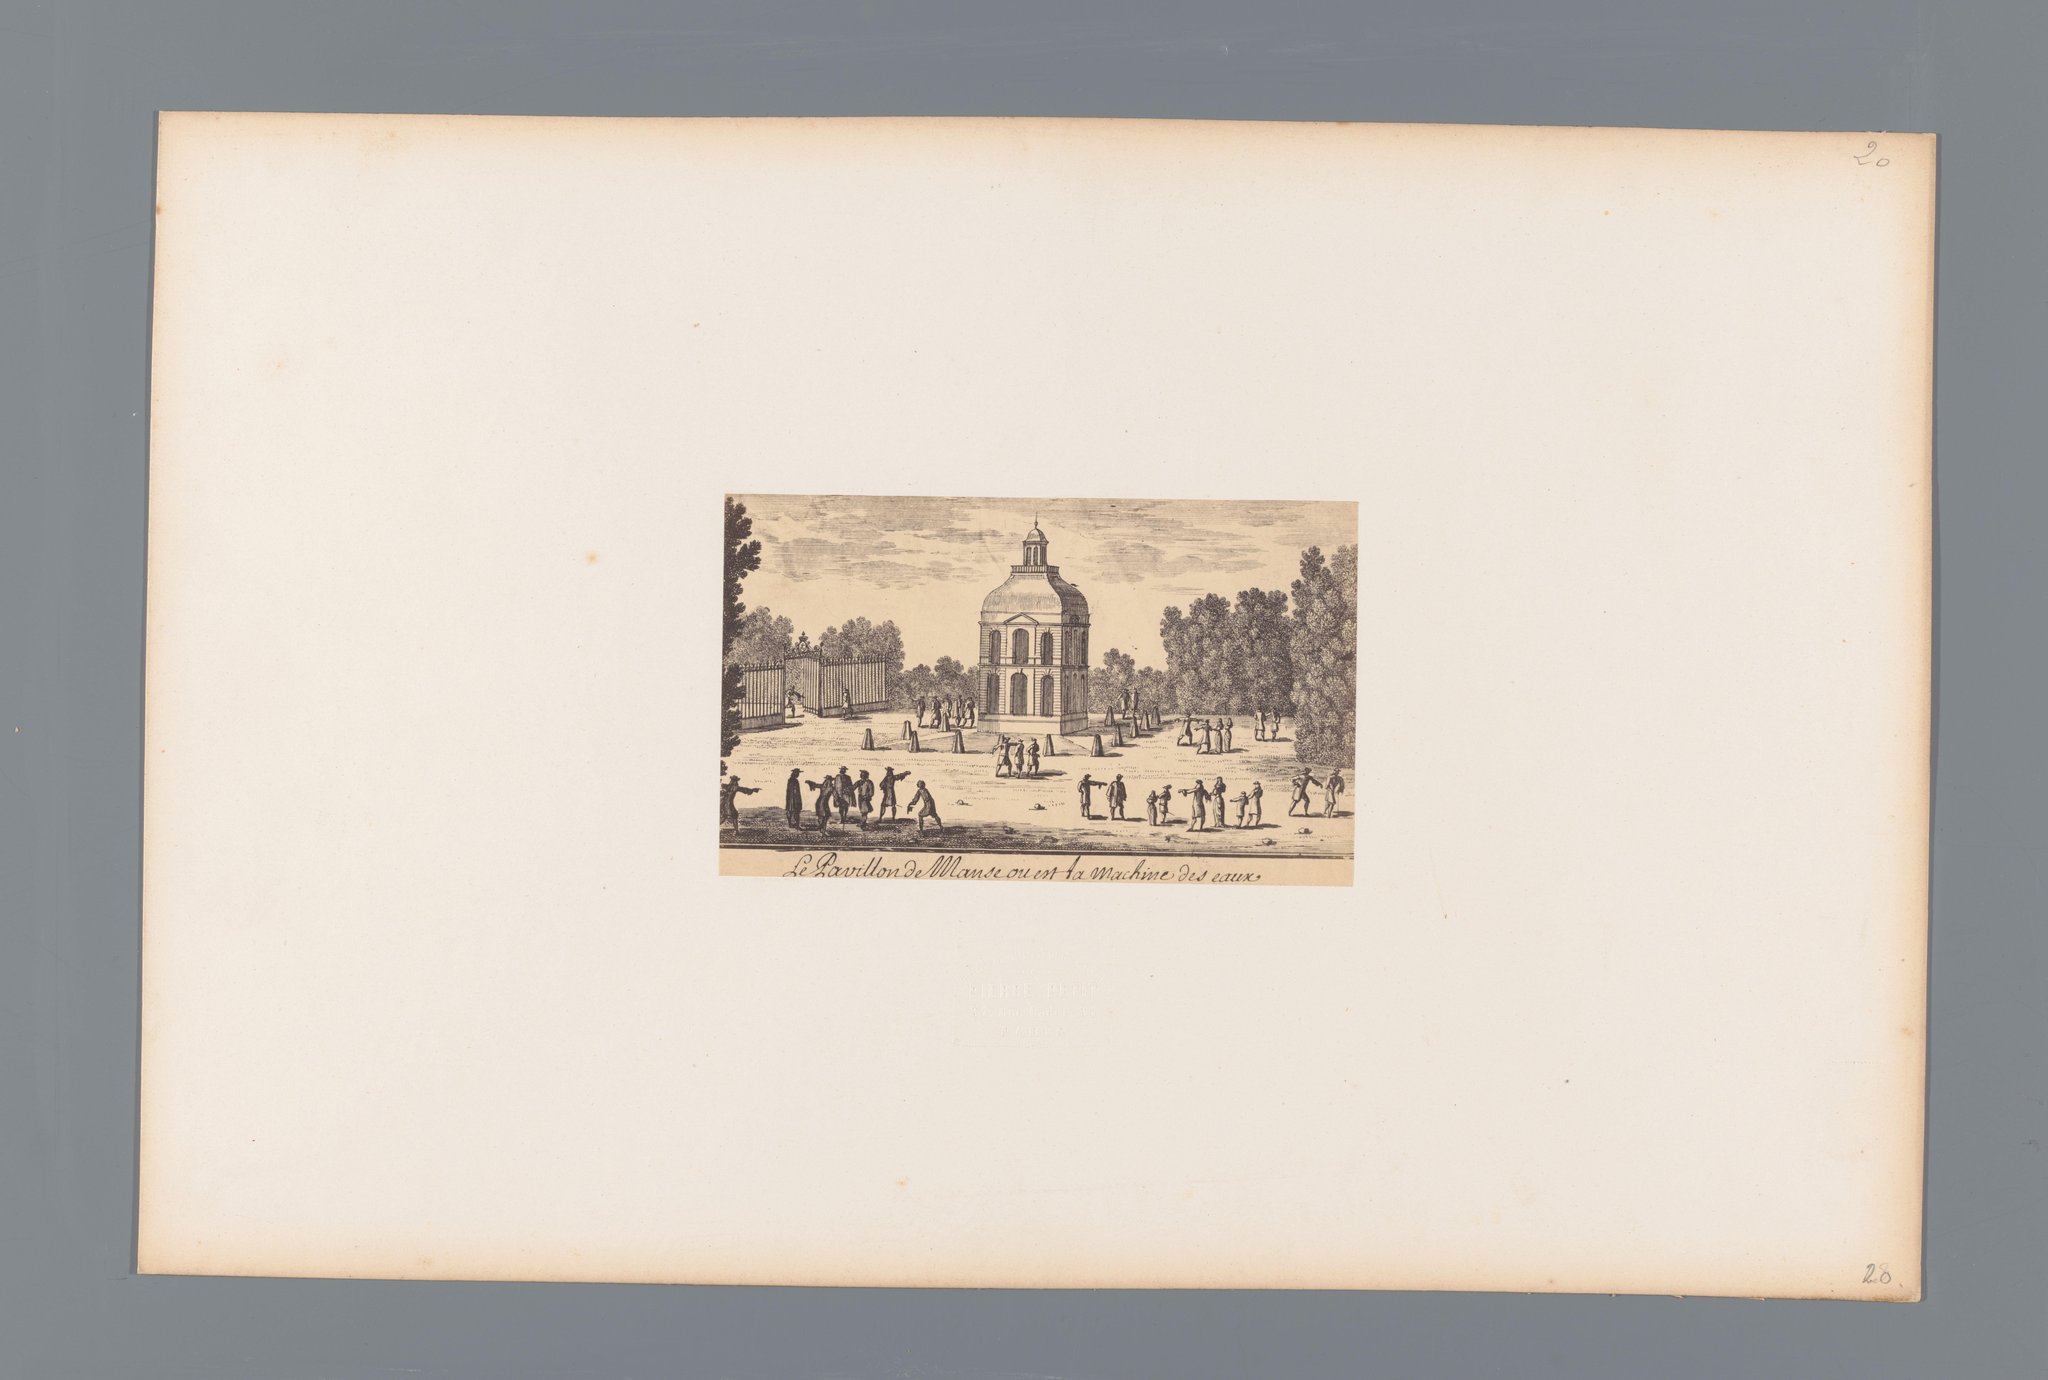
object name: reproduction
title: Fotoreproductie van een ontwerp van de watervoorziening in de tuin van het kasteel van Meudon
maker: pierre petit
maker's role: fotograaf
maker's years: 1832-1909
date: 1860-1865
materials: photographic support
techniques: albumen print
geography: paris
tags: water-supply (~ public services), garden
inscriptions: number: ‘20’, check stamp: ‘PHOTOGRAPHIE des DEUX MONDES/ PIERRE PETIT/ 31, Rue Cadet, 31/ PARIS’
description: Deze foto maakt deel uit van een omslag met 38 foto's en 17 tekstbladen.